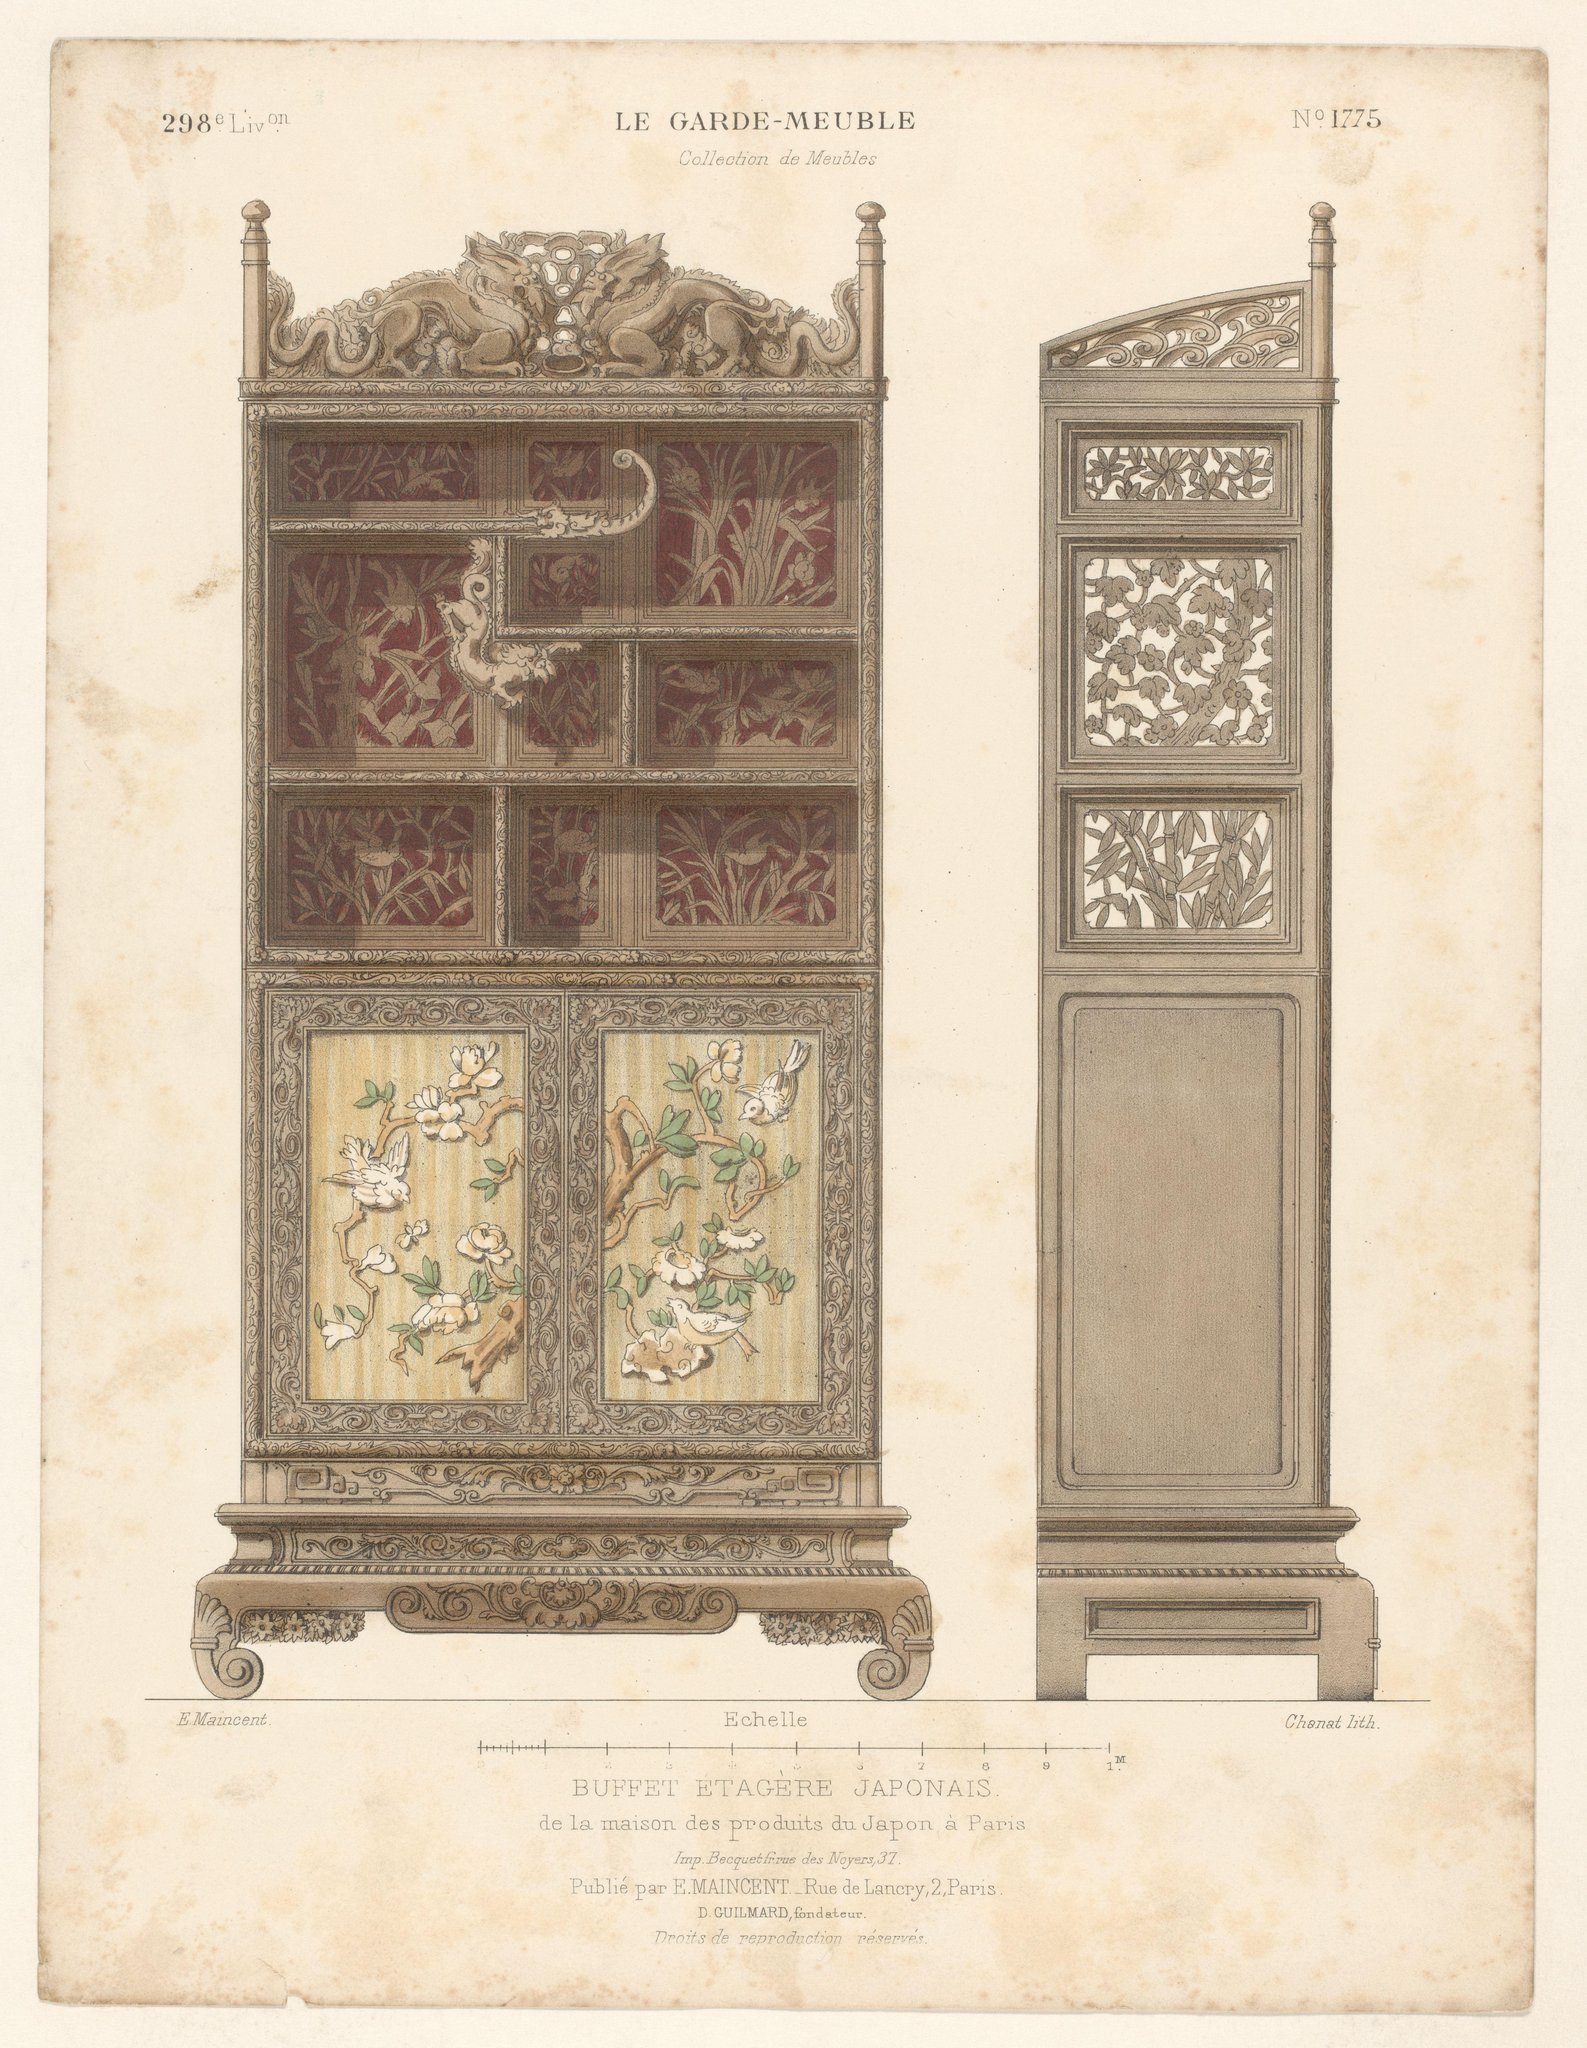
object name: print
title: Buffet étagère Japonais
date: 1885-1895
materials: paper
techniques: hand coloring, lithograph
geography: paris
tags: furniture for storage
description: Ieder Livraison in de serie Le Garde-Meuble bevat negen platen: drie 'sièges' (zitmeubels), drie 'meubles' (diverse meubels zoals tafels en kasten) en drie 'tentures' (gordijnen en draperieën).